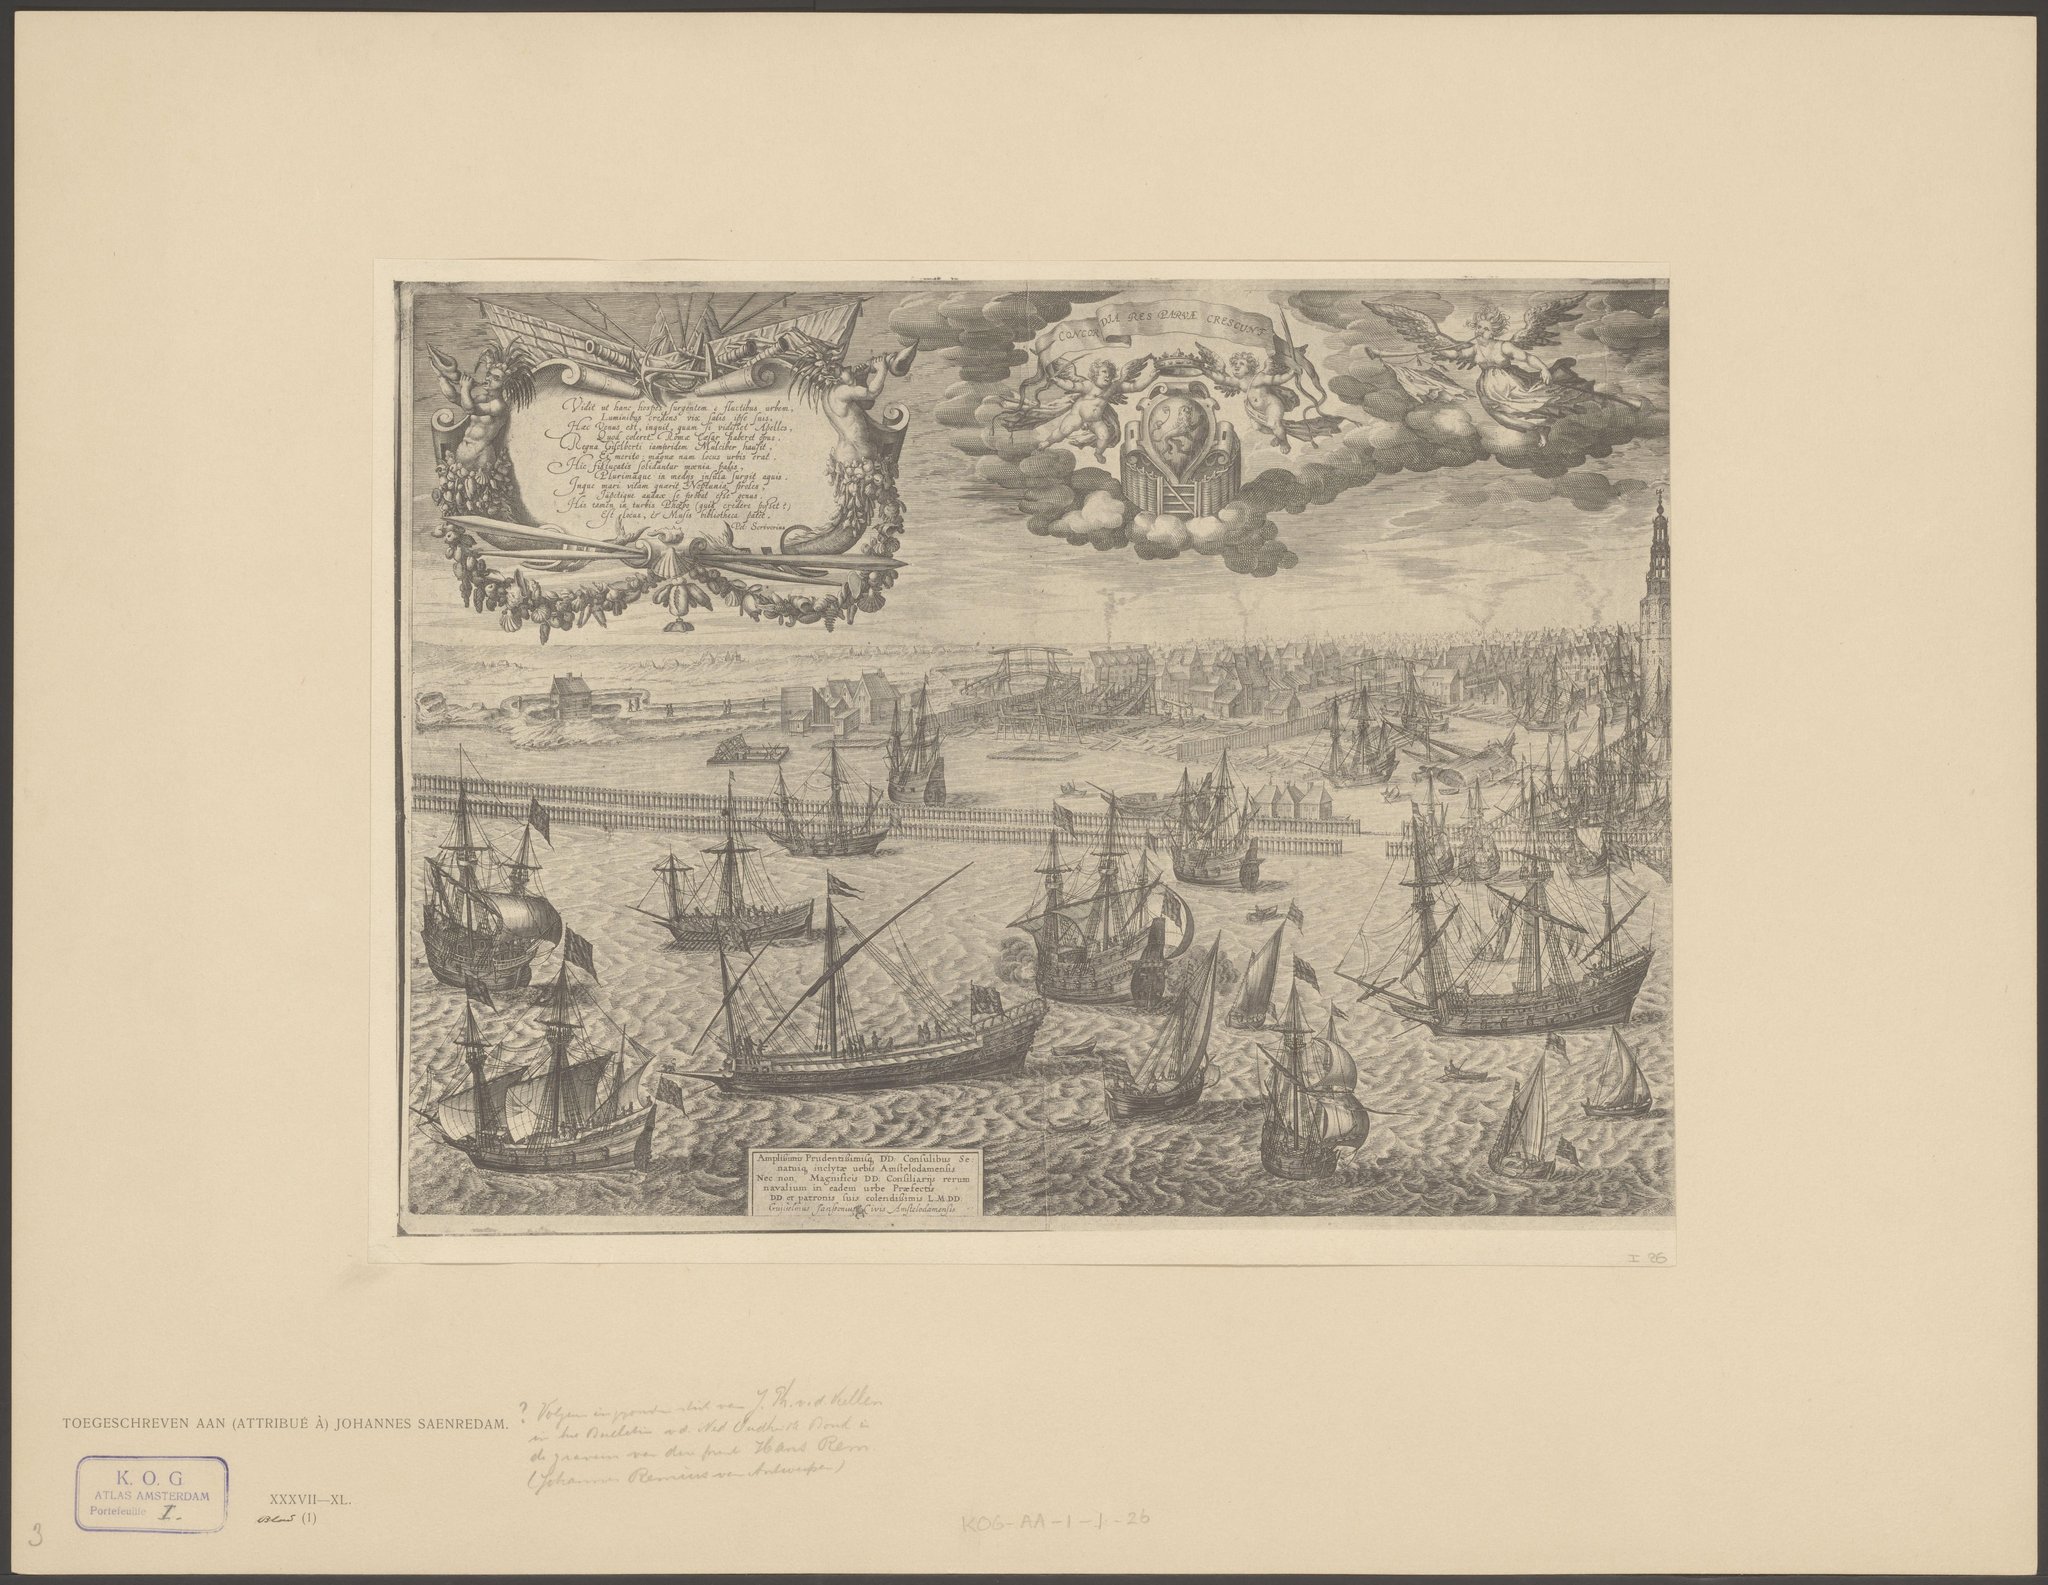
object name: photomechanical print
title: Gezicht op de stad Amsterdam vanaf het IJ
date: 1875-1968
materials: paper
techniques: photograph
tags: city-view in general; 'veduta', river, ships (in general) - cc - more than one ship, amsterdam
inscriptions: collector's mark: ‘1’ Lugt 1641b, inscription: ‘Toegeschreven aan (attribué) (...) Remius van Antwerpen)’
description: Onderwerpsrubriek binnen de Atlas Amsterdam: Gezichten van den geheelen IJkant der Stad.